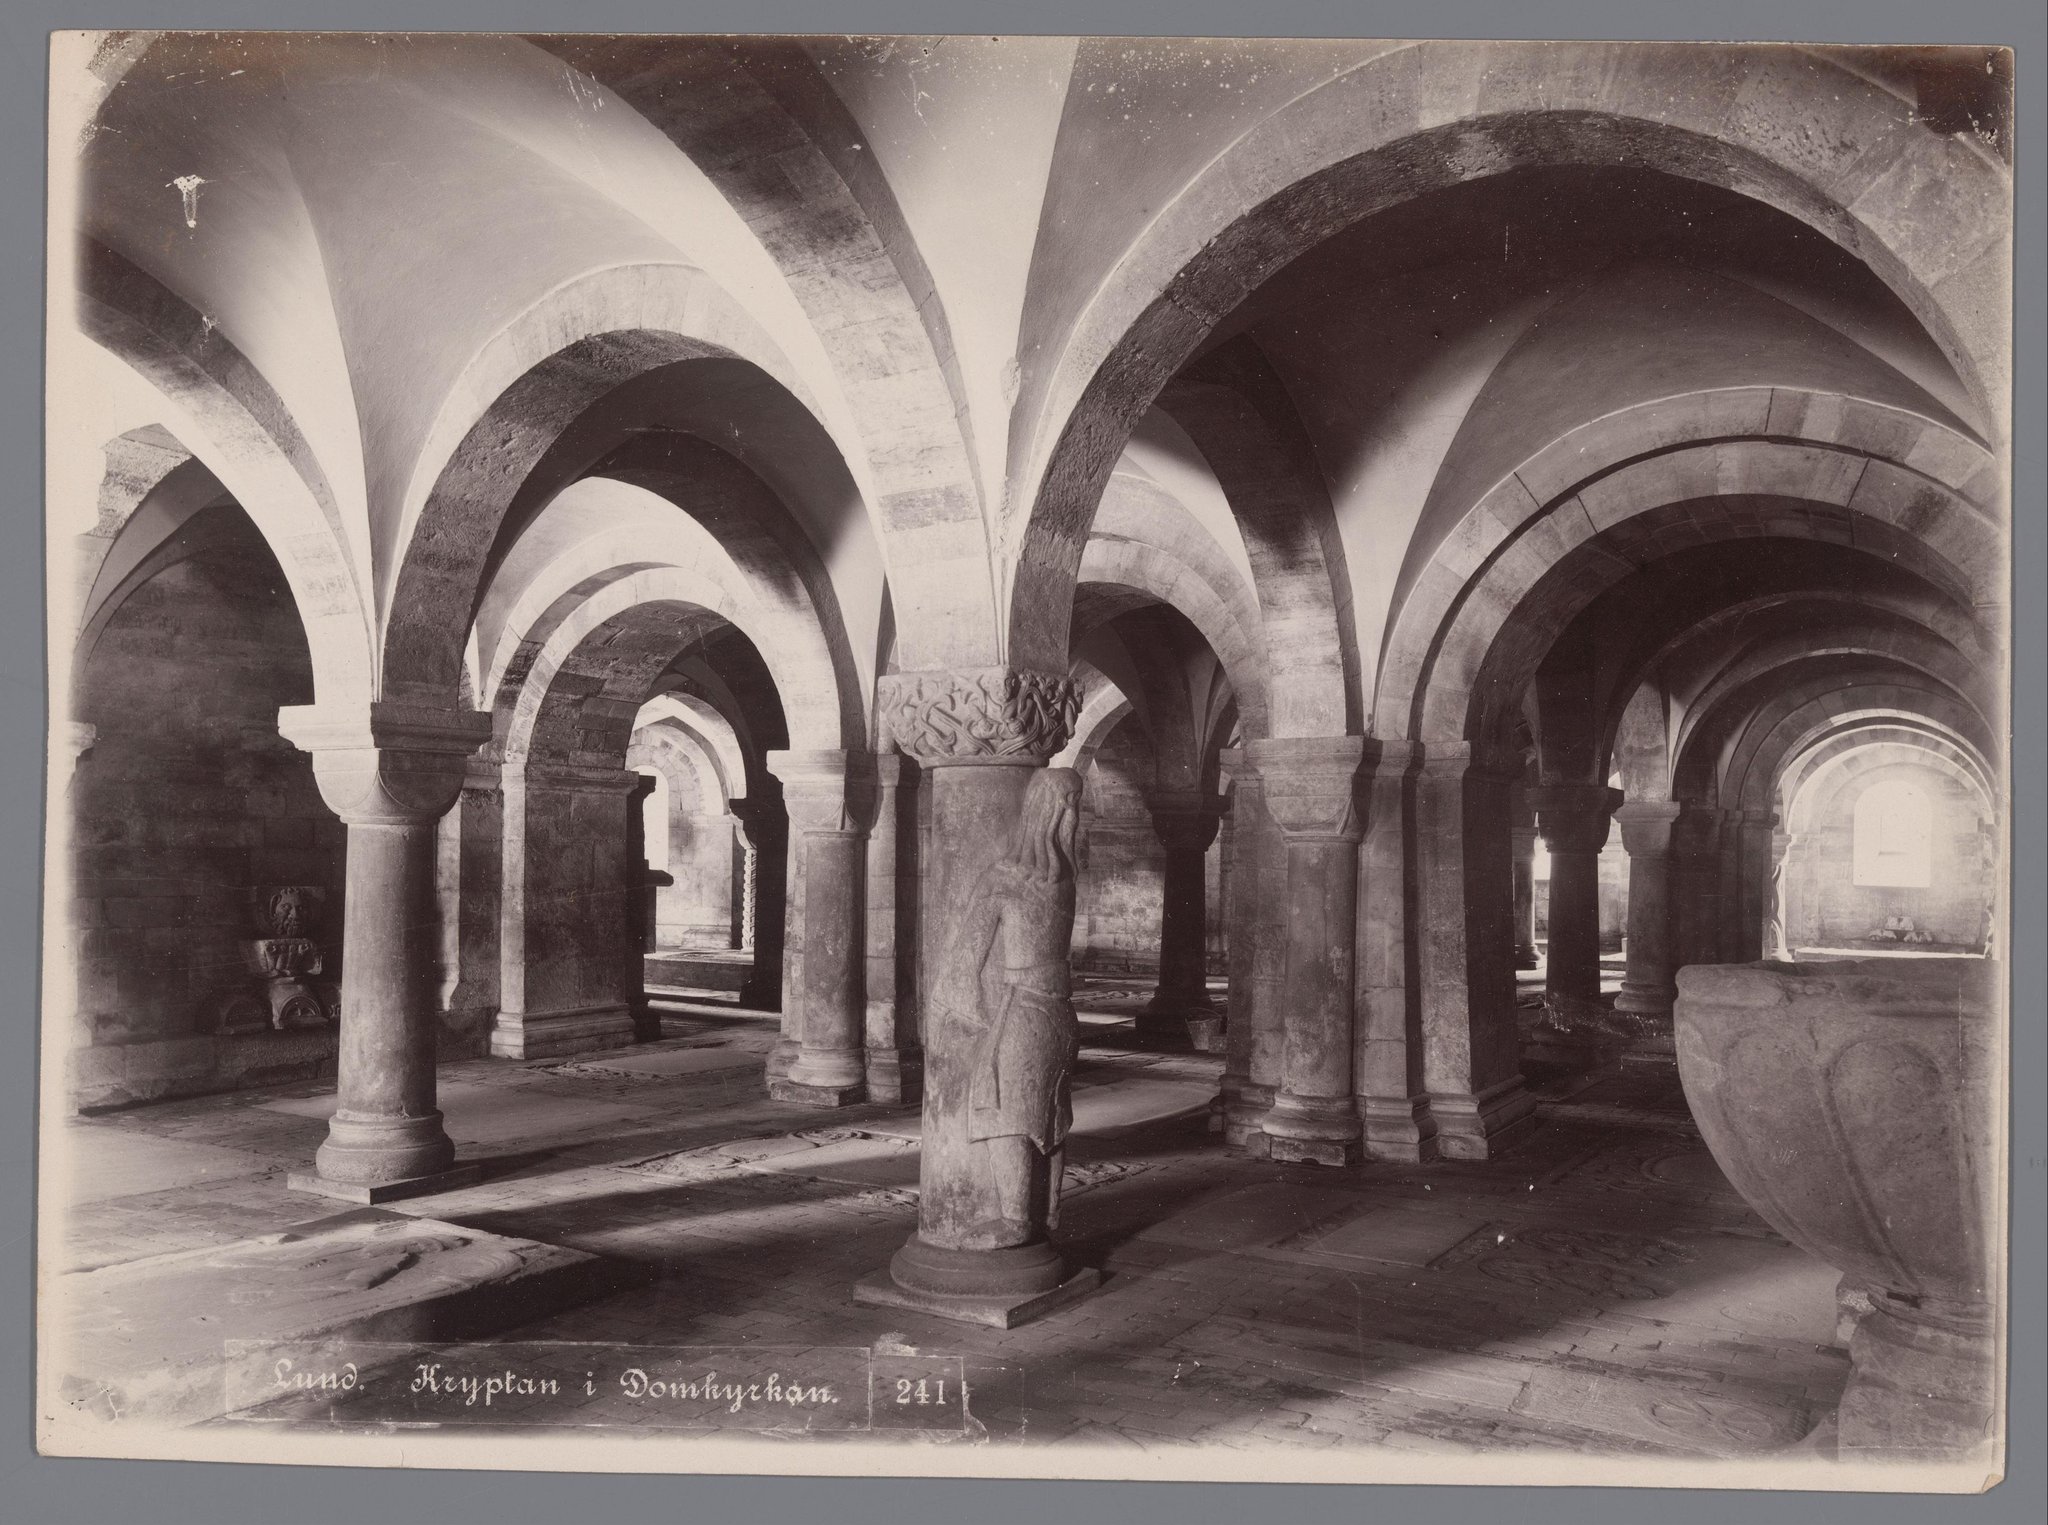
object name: photograph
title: Krytan i Domkyrkan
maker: Anonymous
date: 1915-1960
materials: paper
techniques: gelatin silver print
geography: lund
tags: parts of church interior (crypt)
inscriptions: number: ‘241’